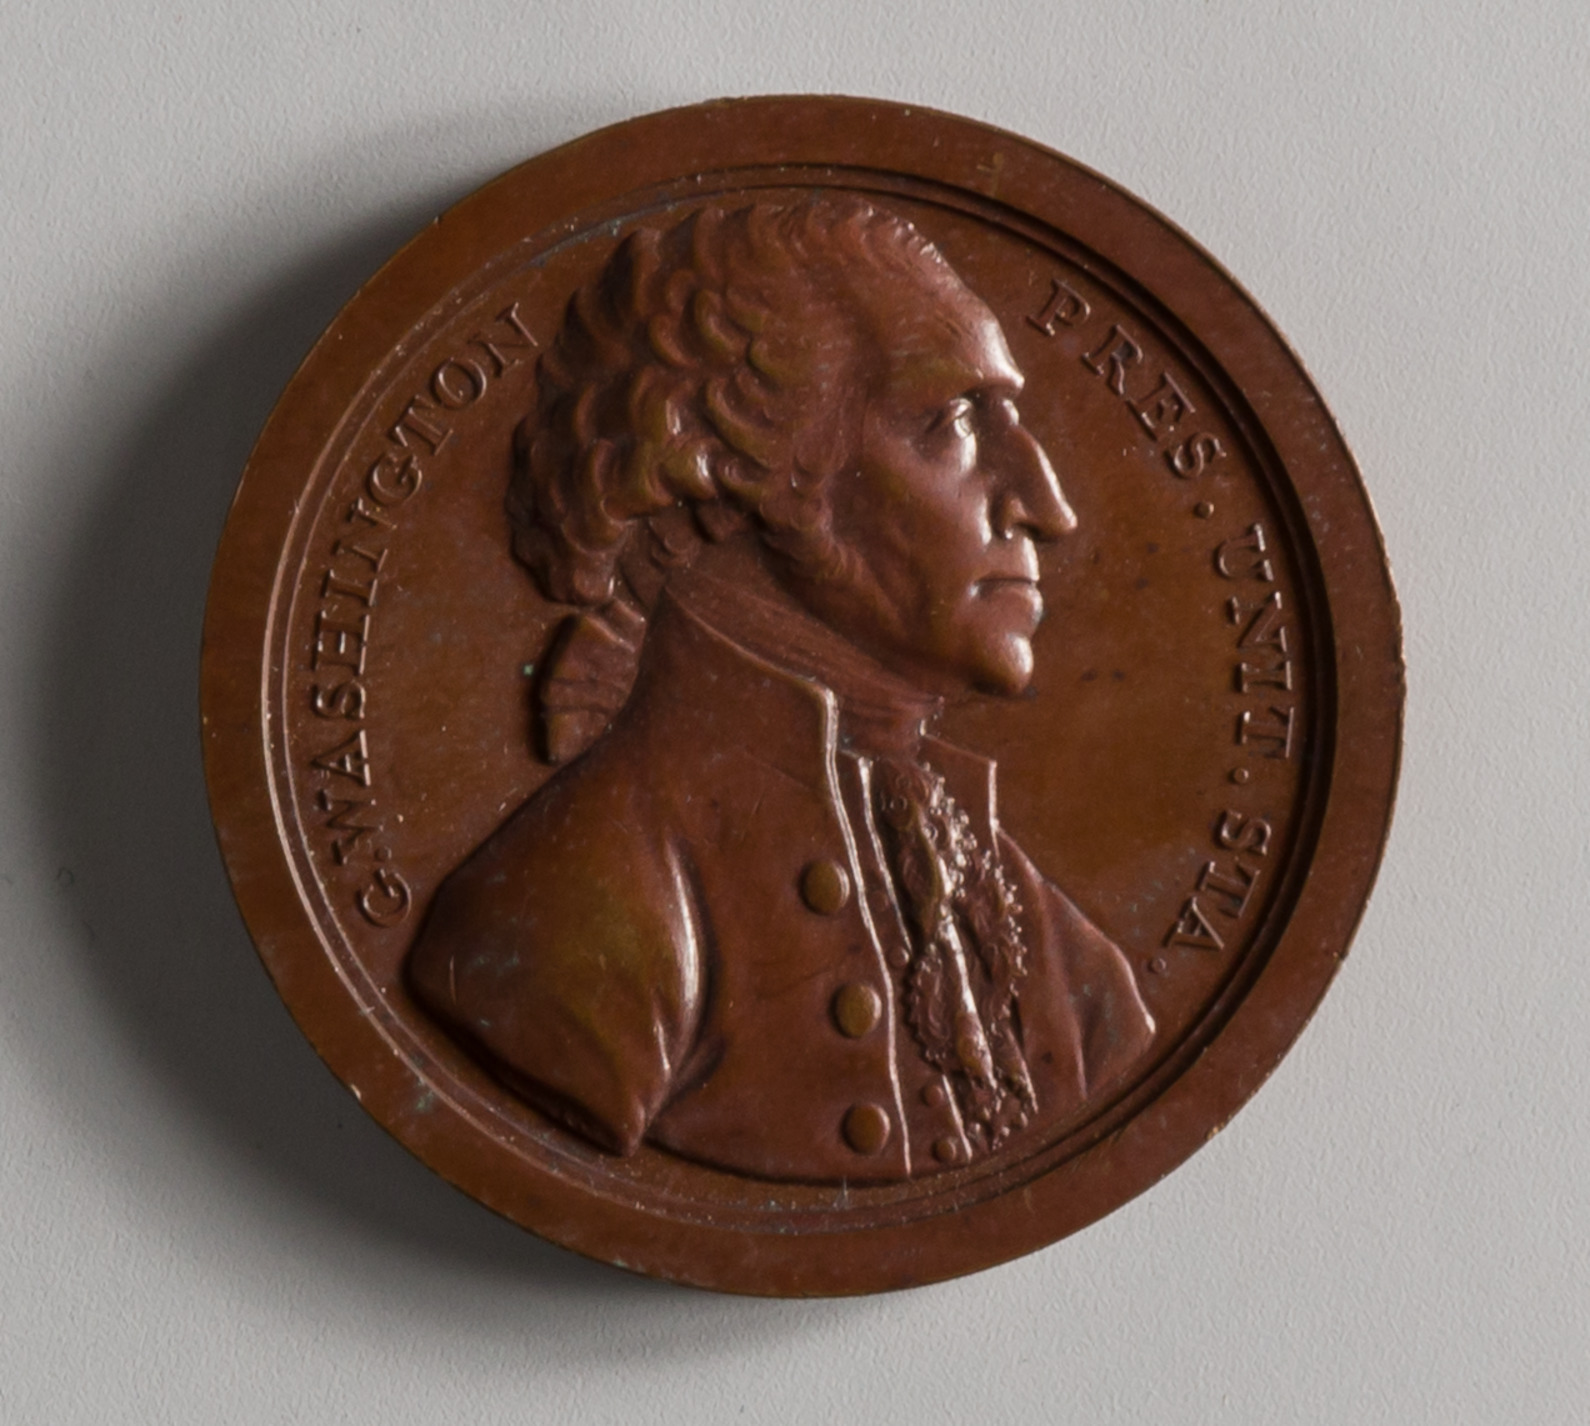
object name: medal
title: George Washington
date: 1797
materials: bronze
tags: george washington,portraits,profiles